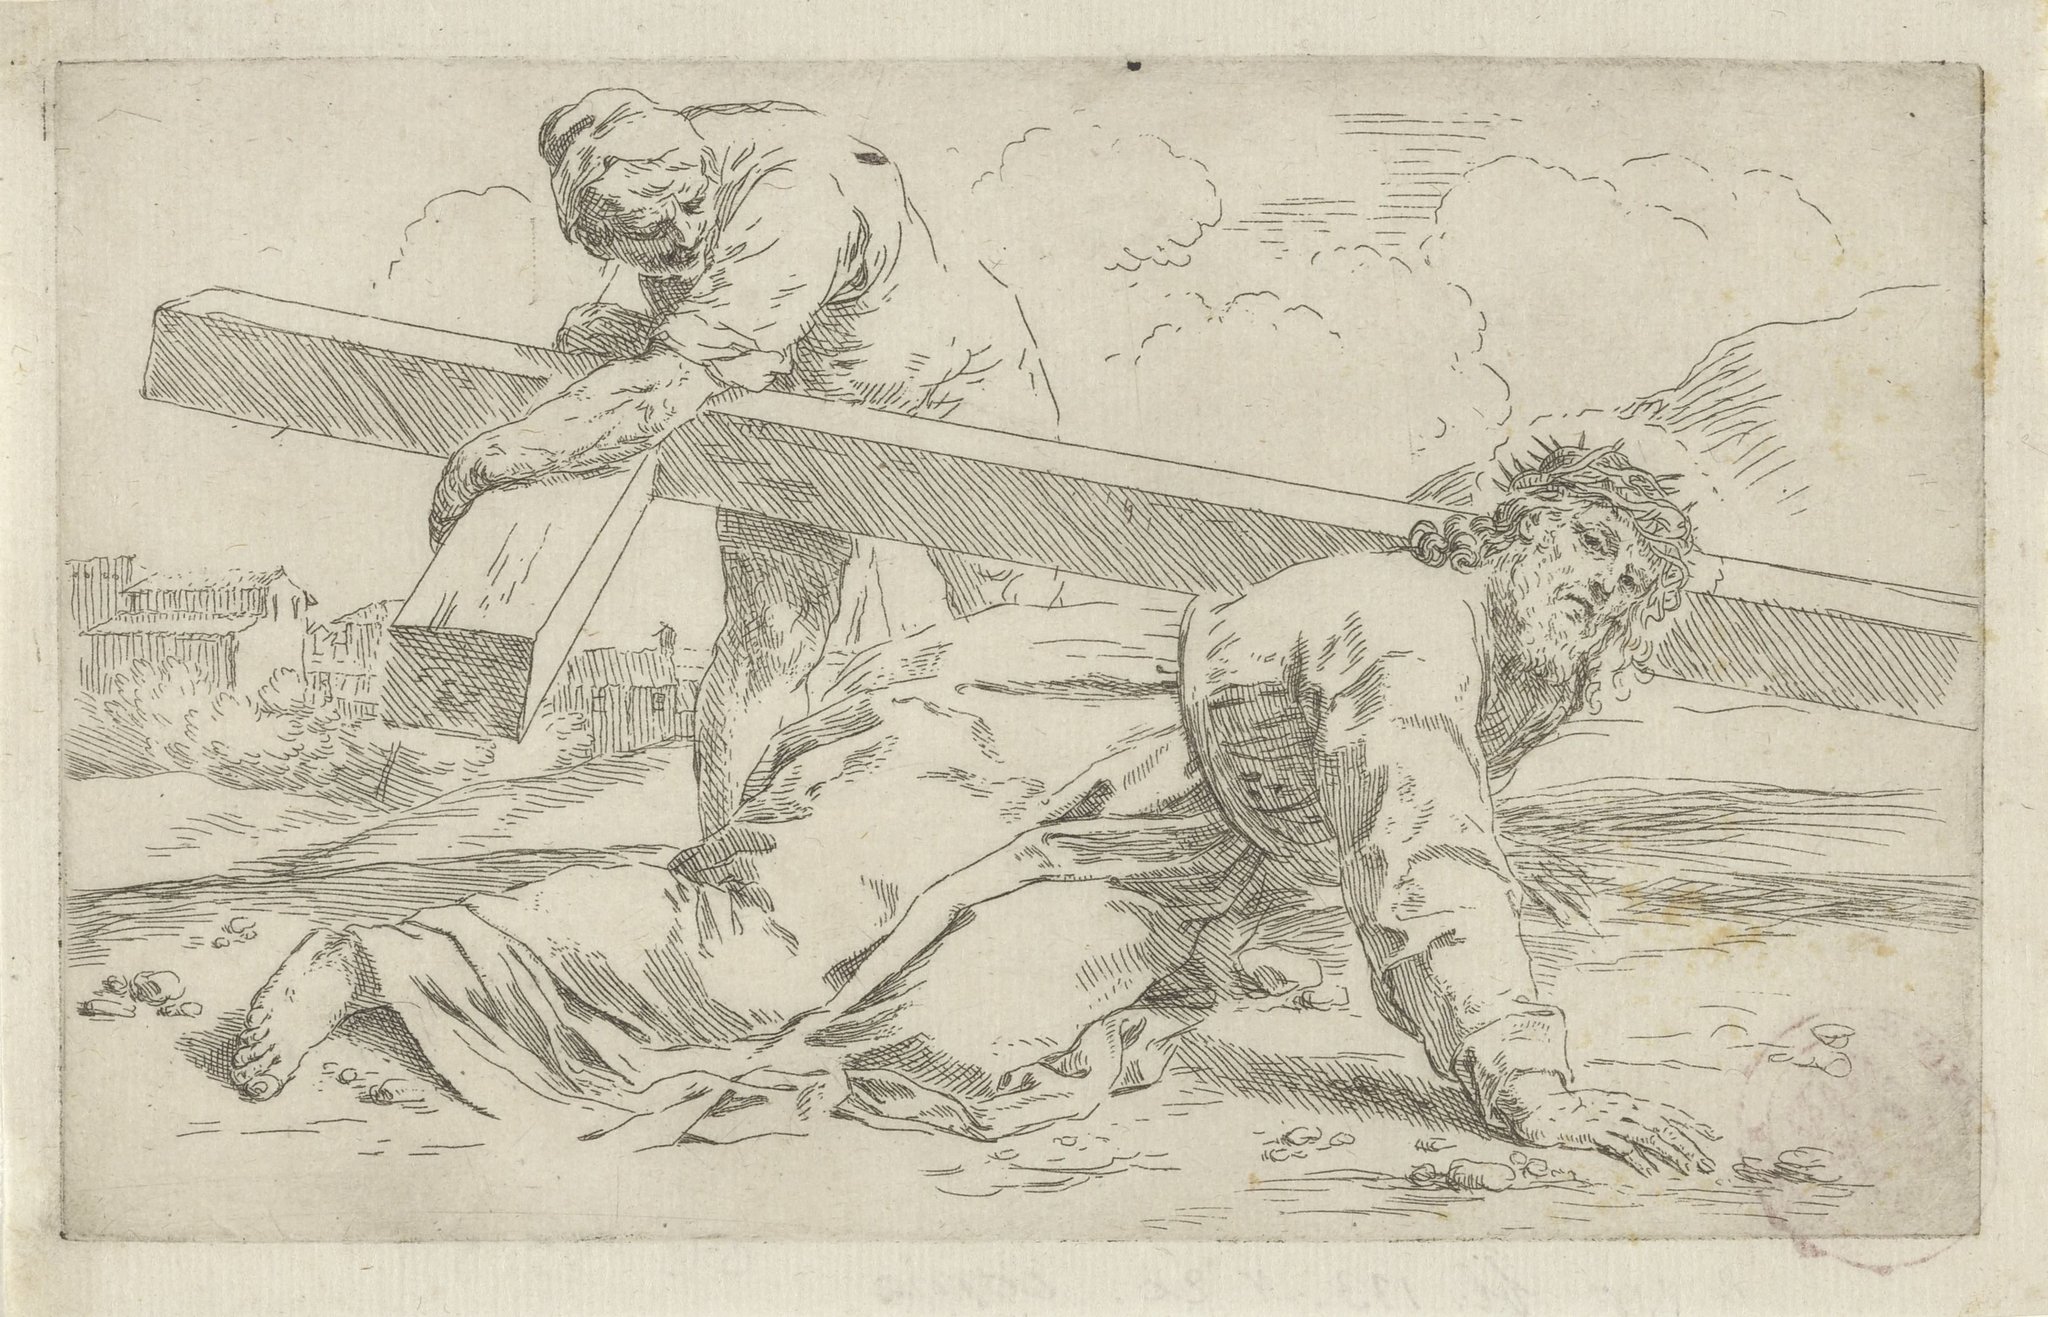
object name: print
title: Christus bezwijkt onder het gewicht van het kruis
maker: simone cantarini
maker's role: draughtsman, print maker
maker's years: 1612-1648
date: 1622-1648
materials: paper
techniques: etching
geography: italy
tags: carrying of the cross: christ bearing the cross, alone or with the help of others (e.g. simon the cyrenian)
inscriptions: collector's mark: Lugt 240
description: Christus bezwijkt onder het gewicht van het kruis dat hij op zijn schouders draagt op de weg naar Golgota. Een man trekt aan het kruis.